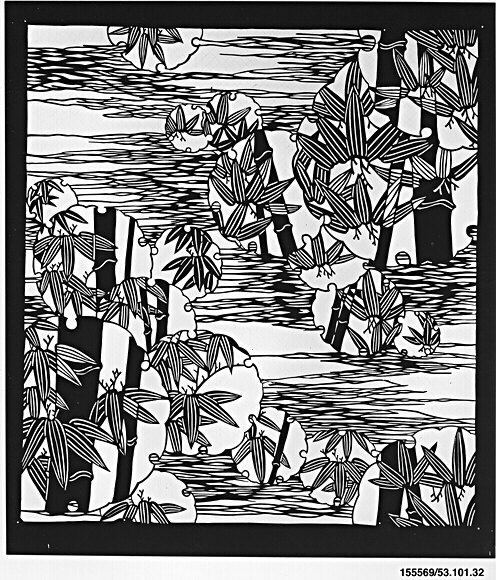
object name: stencil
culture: japanese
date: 1615-1868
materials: paper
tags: bamboo